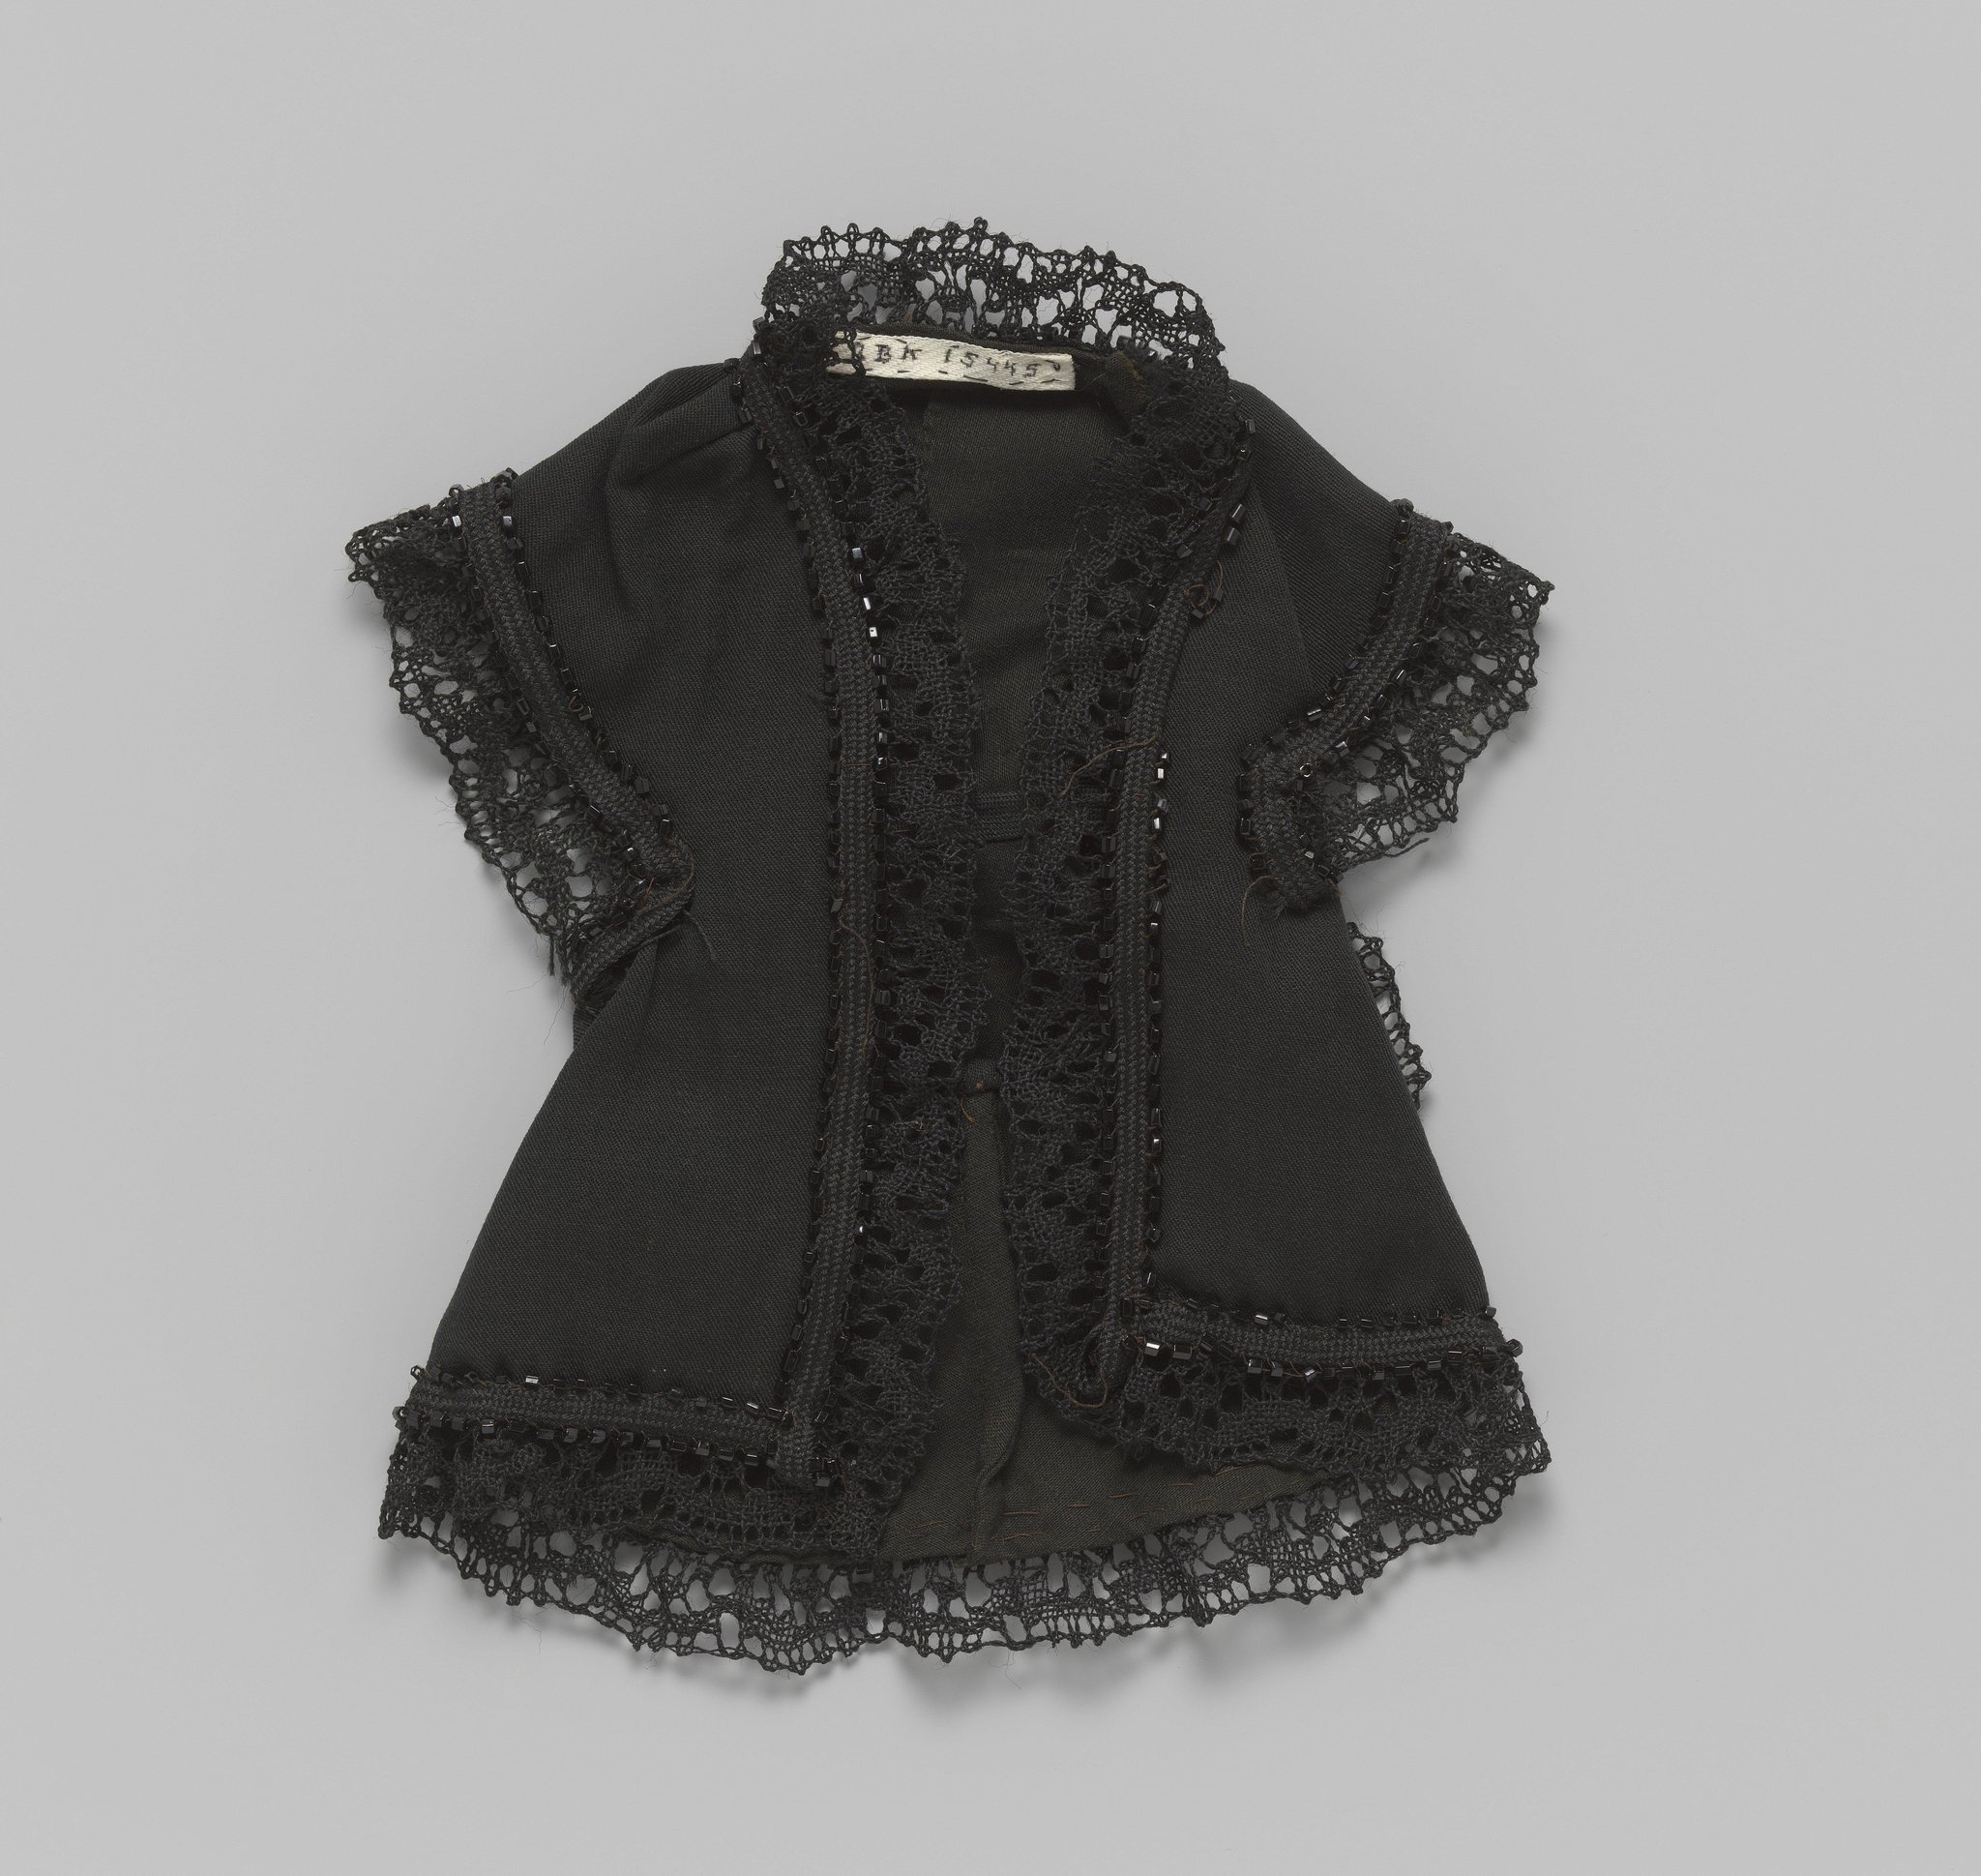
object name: doll's clothing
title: Zwarte hes afgezet met kant en kralen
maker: Anonymous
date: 1850-1920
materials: textile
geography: europe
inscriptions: number: ‘RBK 15445’